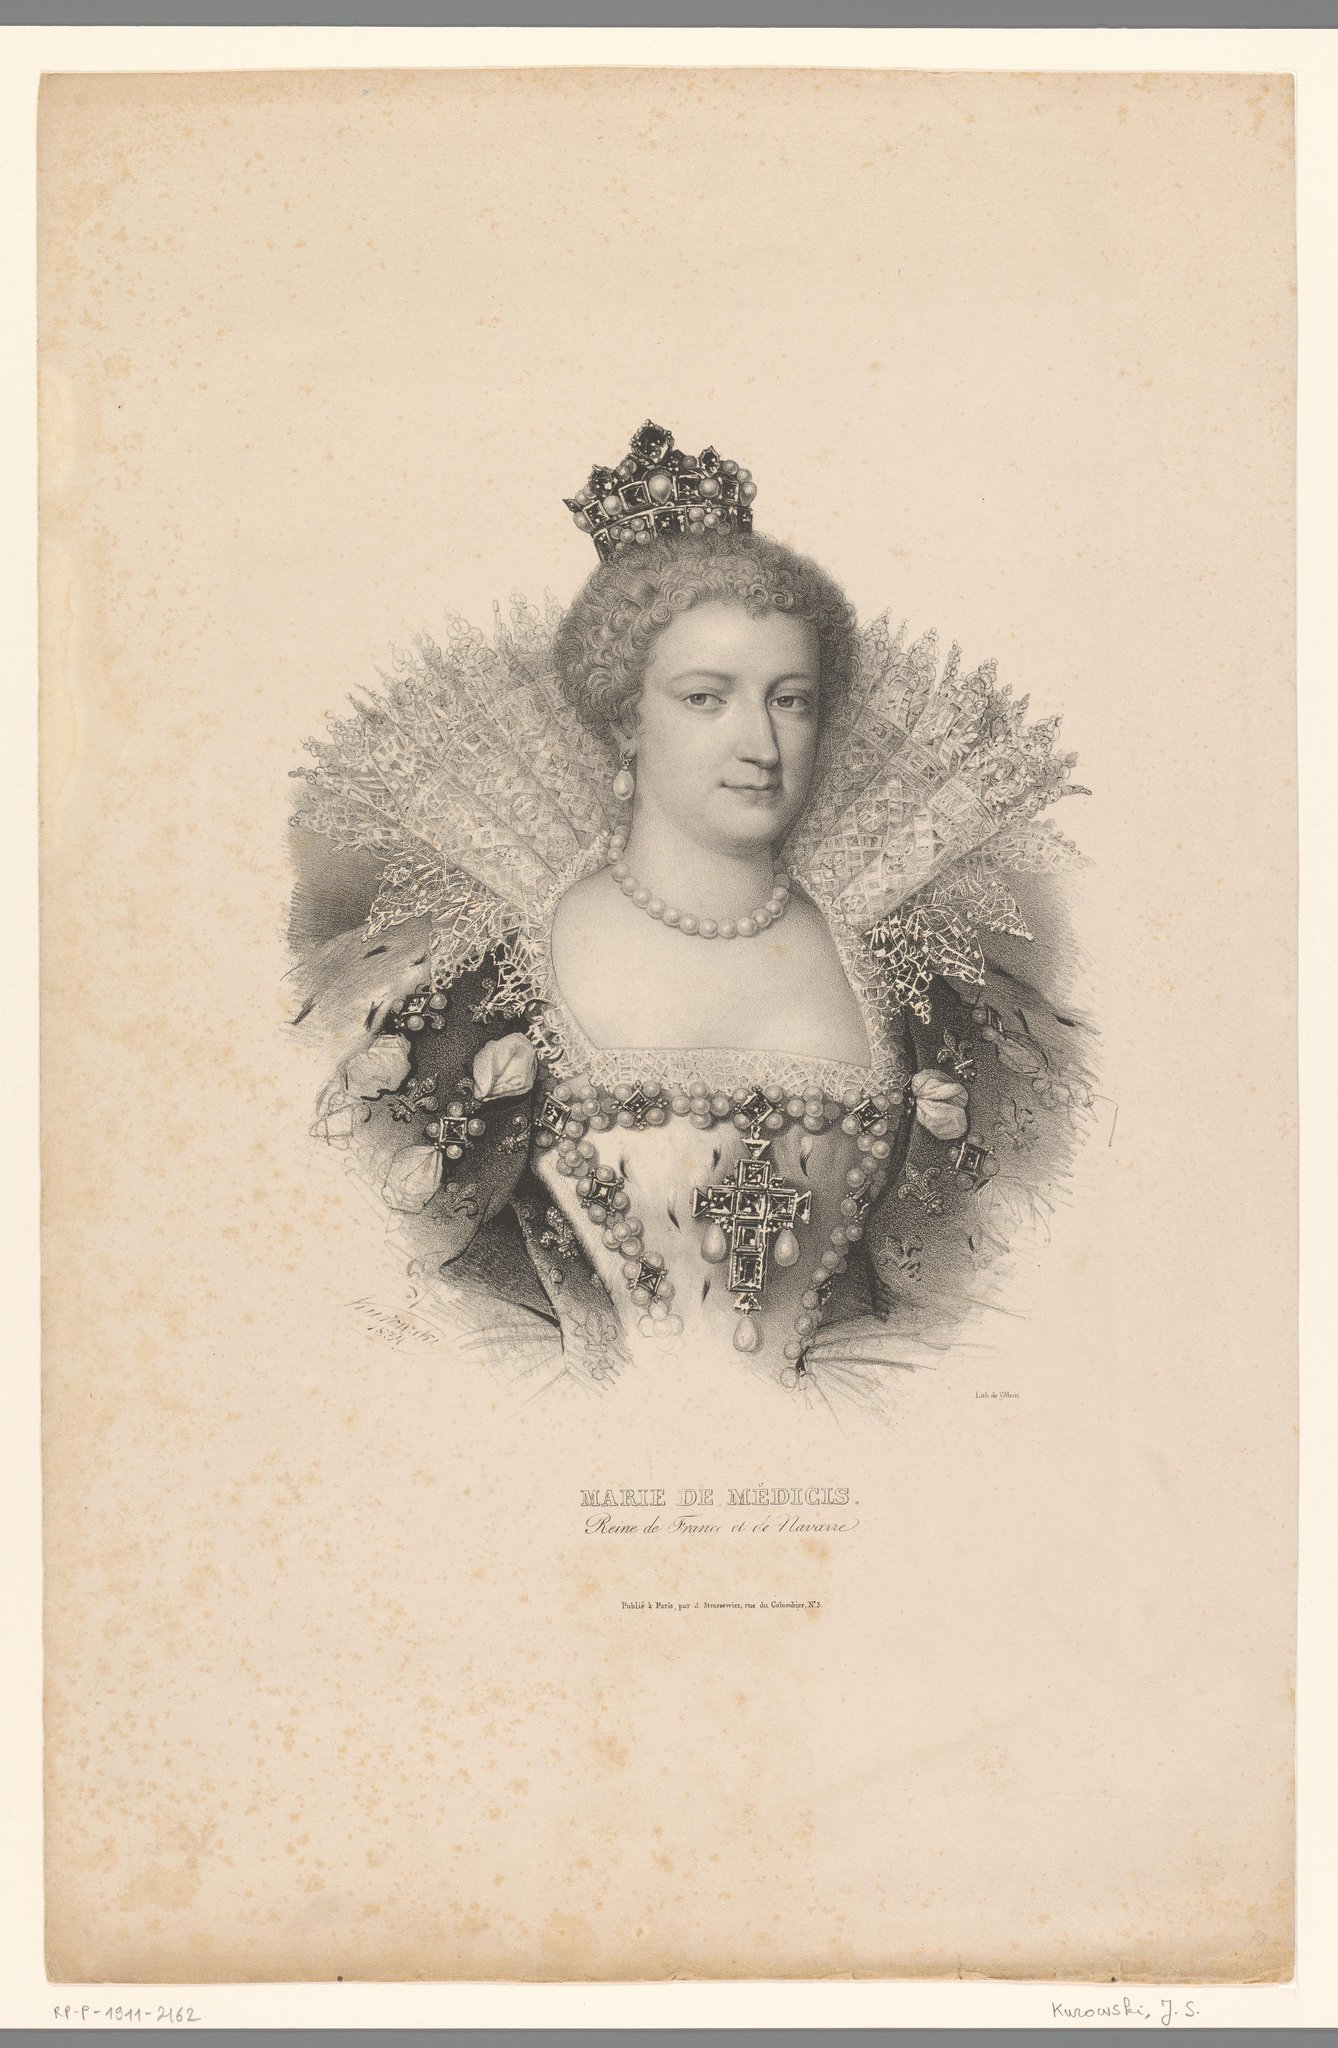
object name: print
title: Marie de Médicis, Reine de France et de Navarre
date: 1834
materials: paper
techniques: lithograph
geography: paris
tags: print maker, maria de' medici, adult woman, historical persons, ornaments, jewels, neck-gear: collar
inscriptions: collector's mark: Lugt 2228